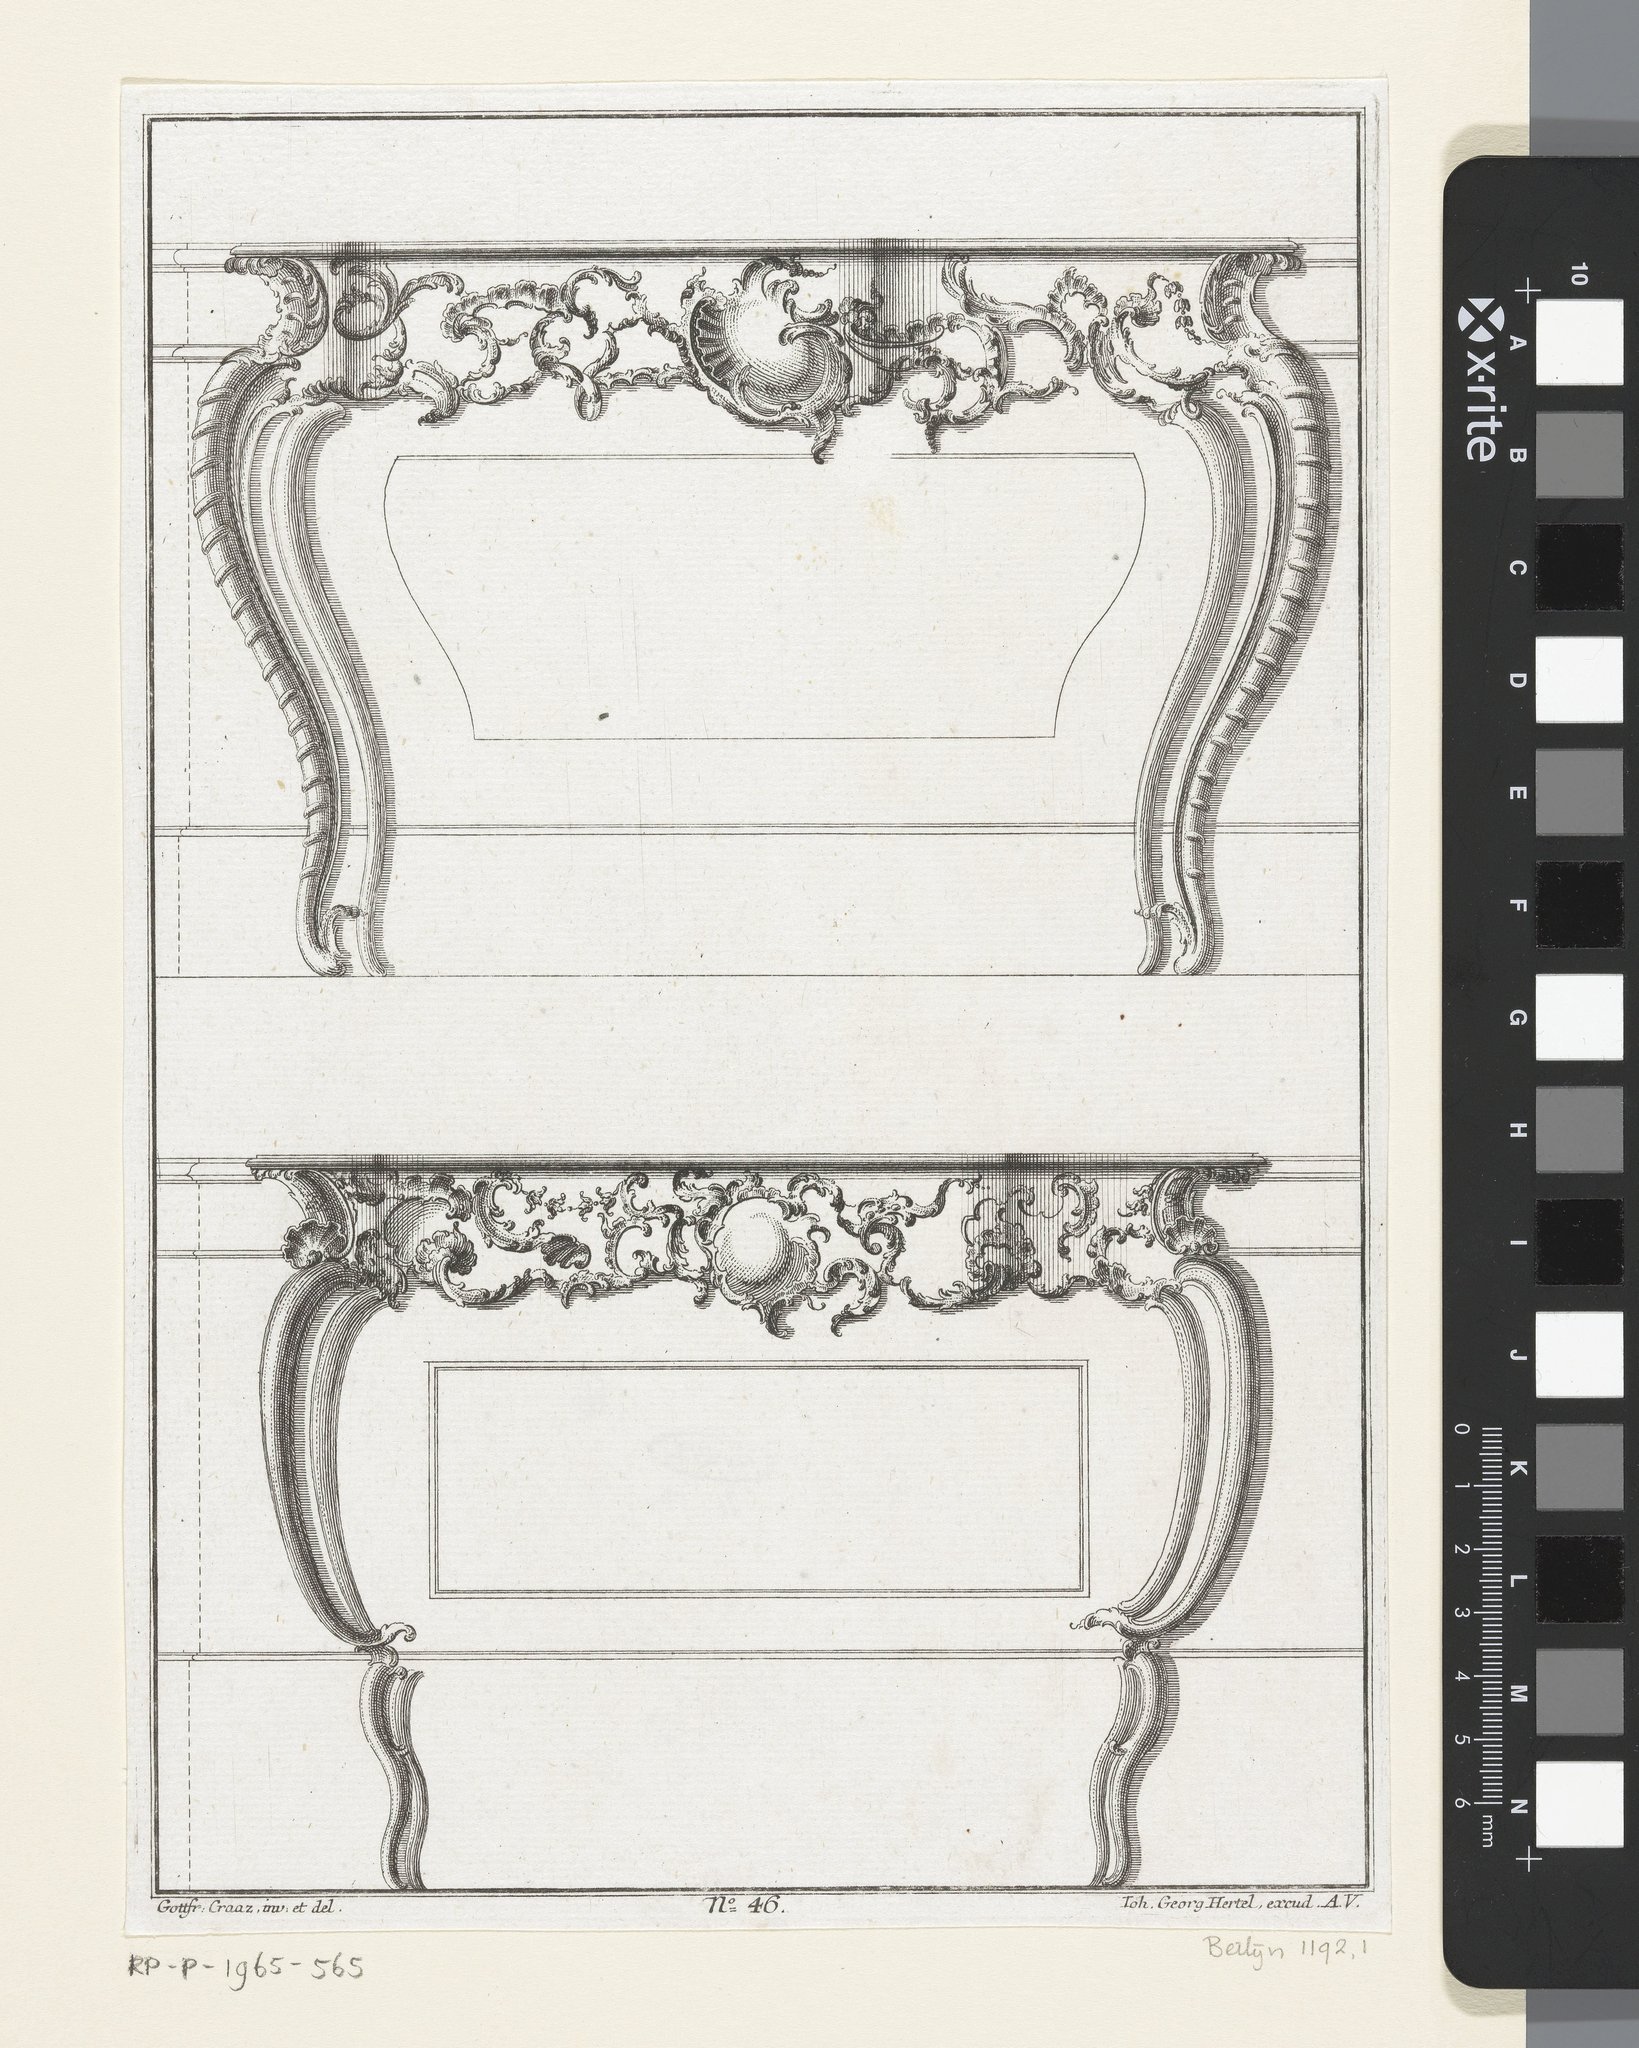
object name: print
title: Wandtafelontwerpen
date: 1730-1775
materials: paper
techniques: etching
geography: germany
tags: rocaille ornament, table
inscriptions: collector's mark: Lugt 2760, collector's mark: Lugt 2228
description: Midden onder 46 genummerd. Deze prent maakt deel uit van een serie van vier.